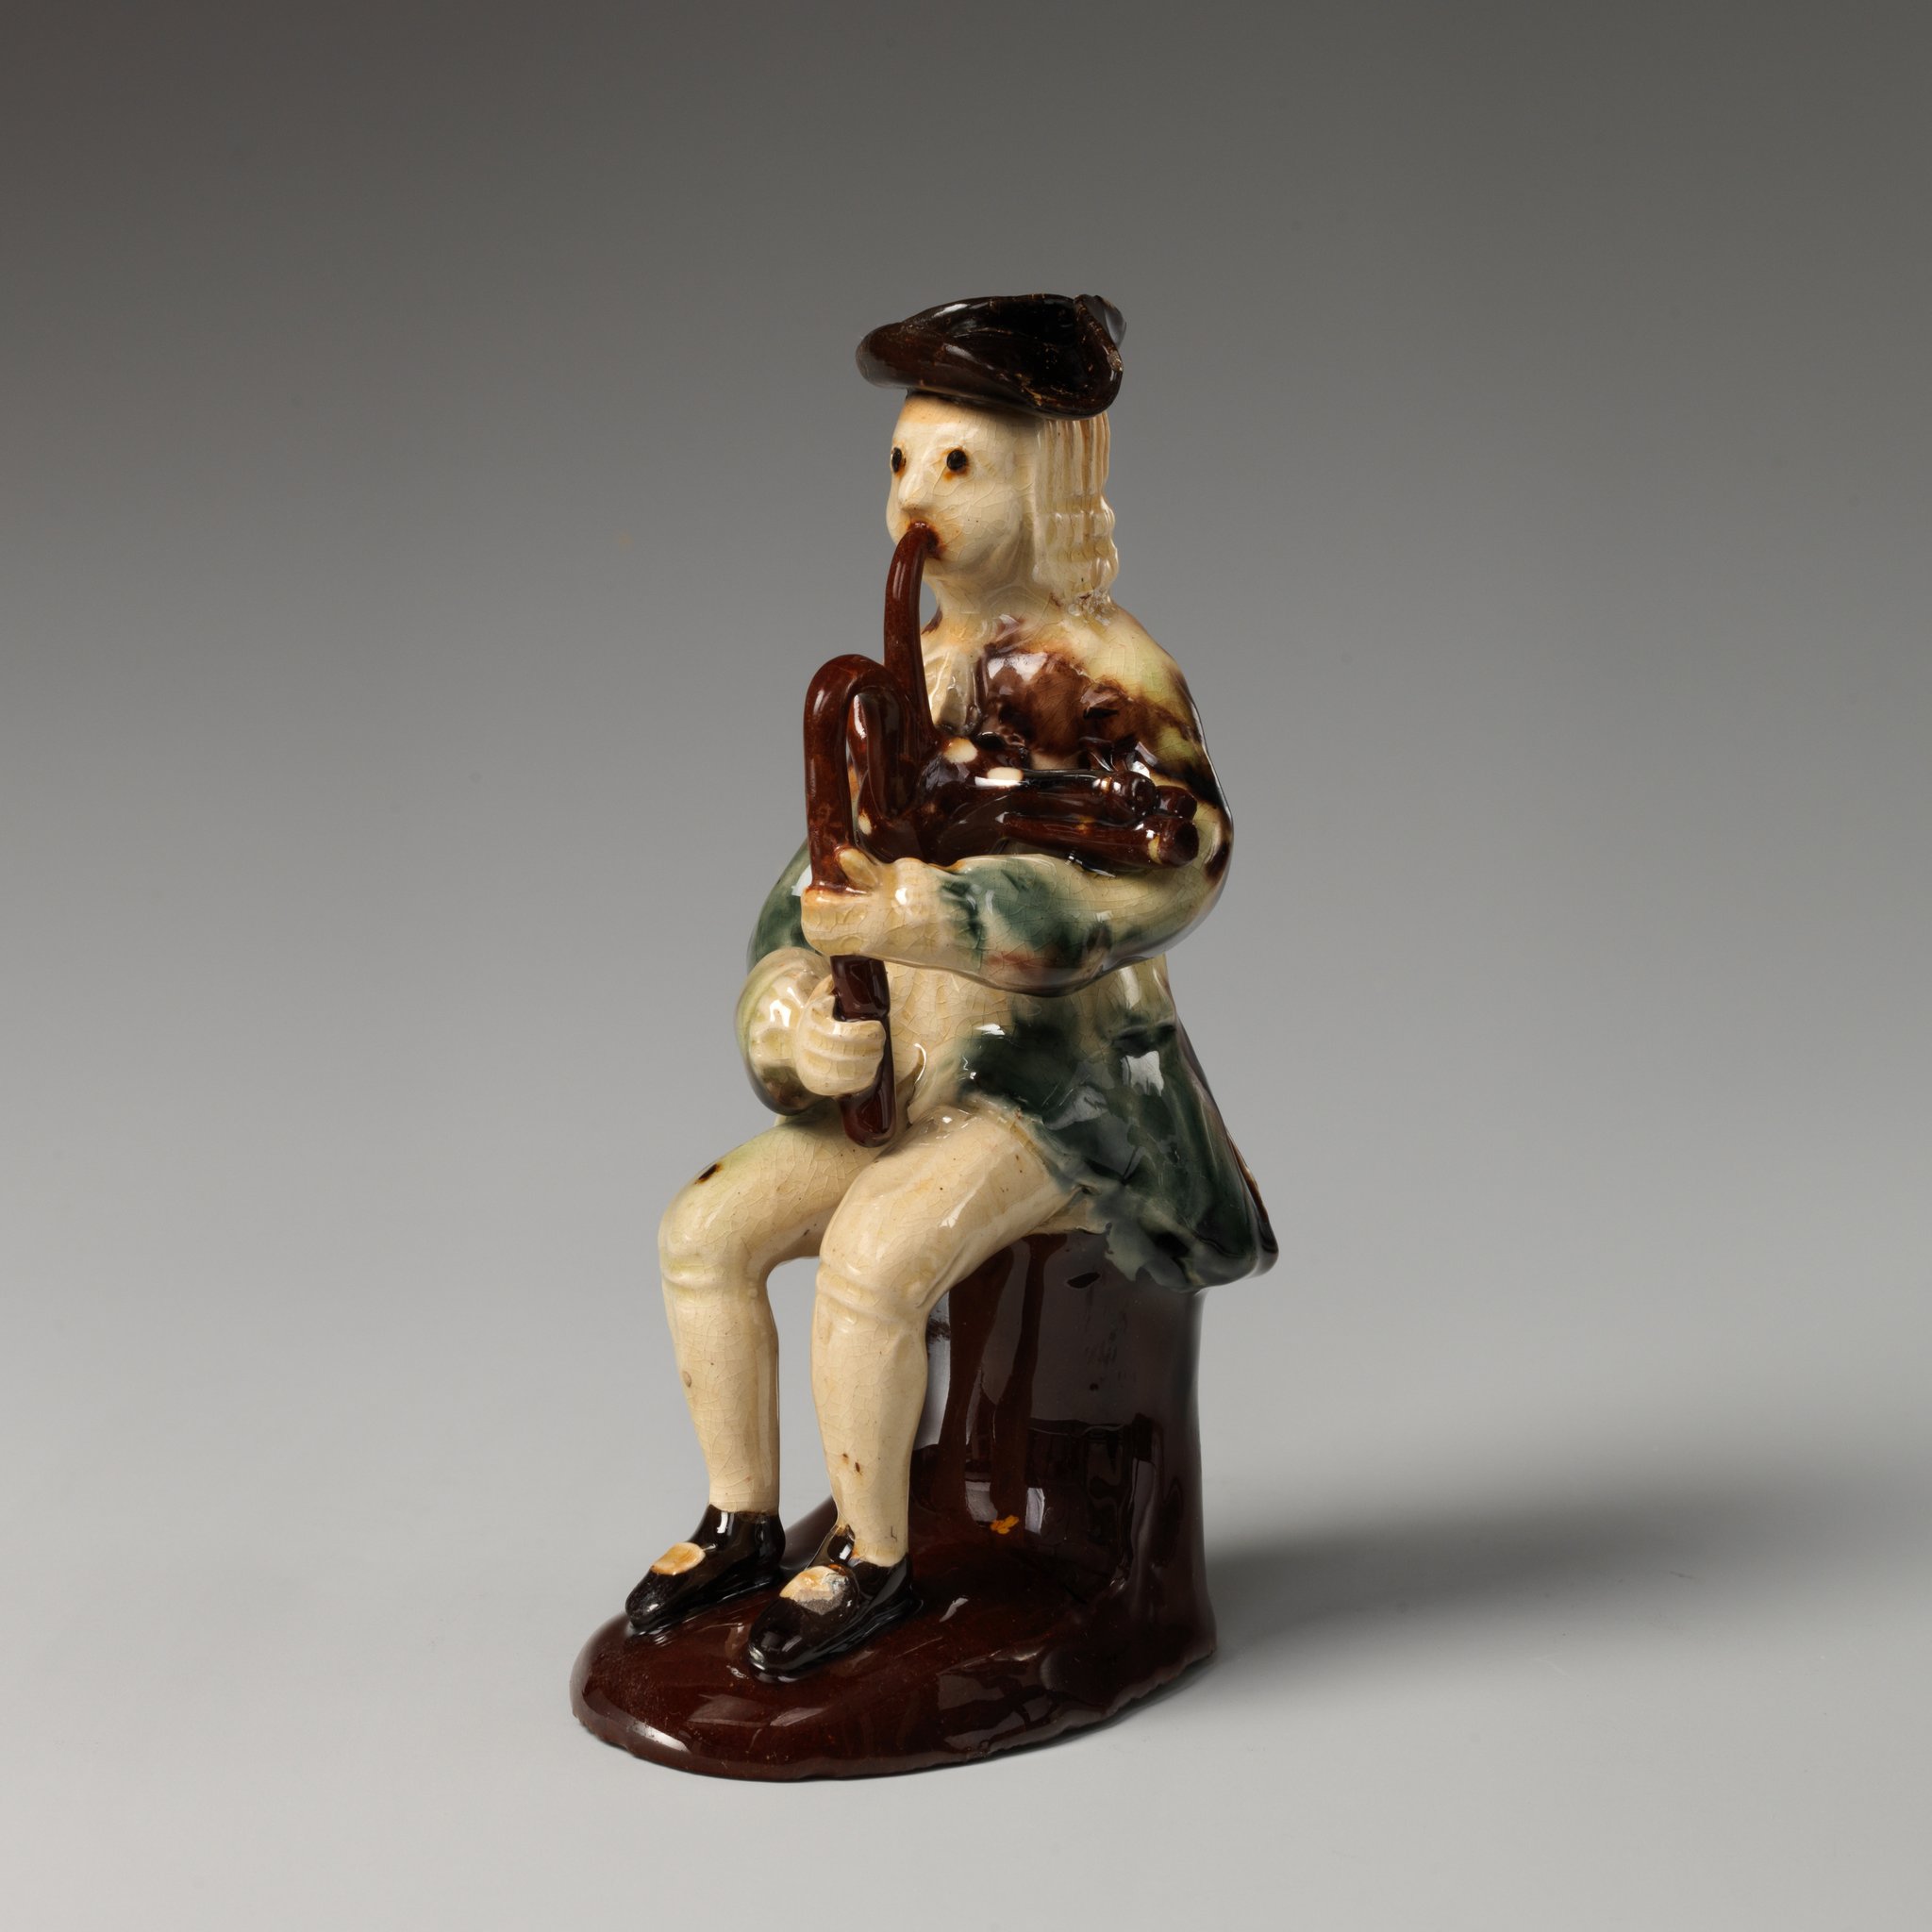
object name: figure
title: Bagpiper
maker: astbury-whieldon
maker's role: maker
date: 1745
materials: earthenware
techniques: glazing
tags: men,bagpipes